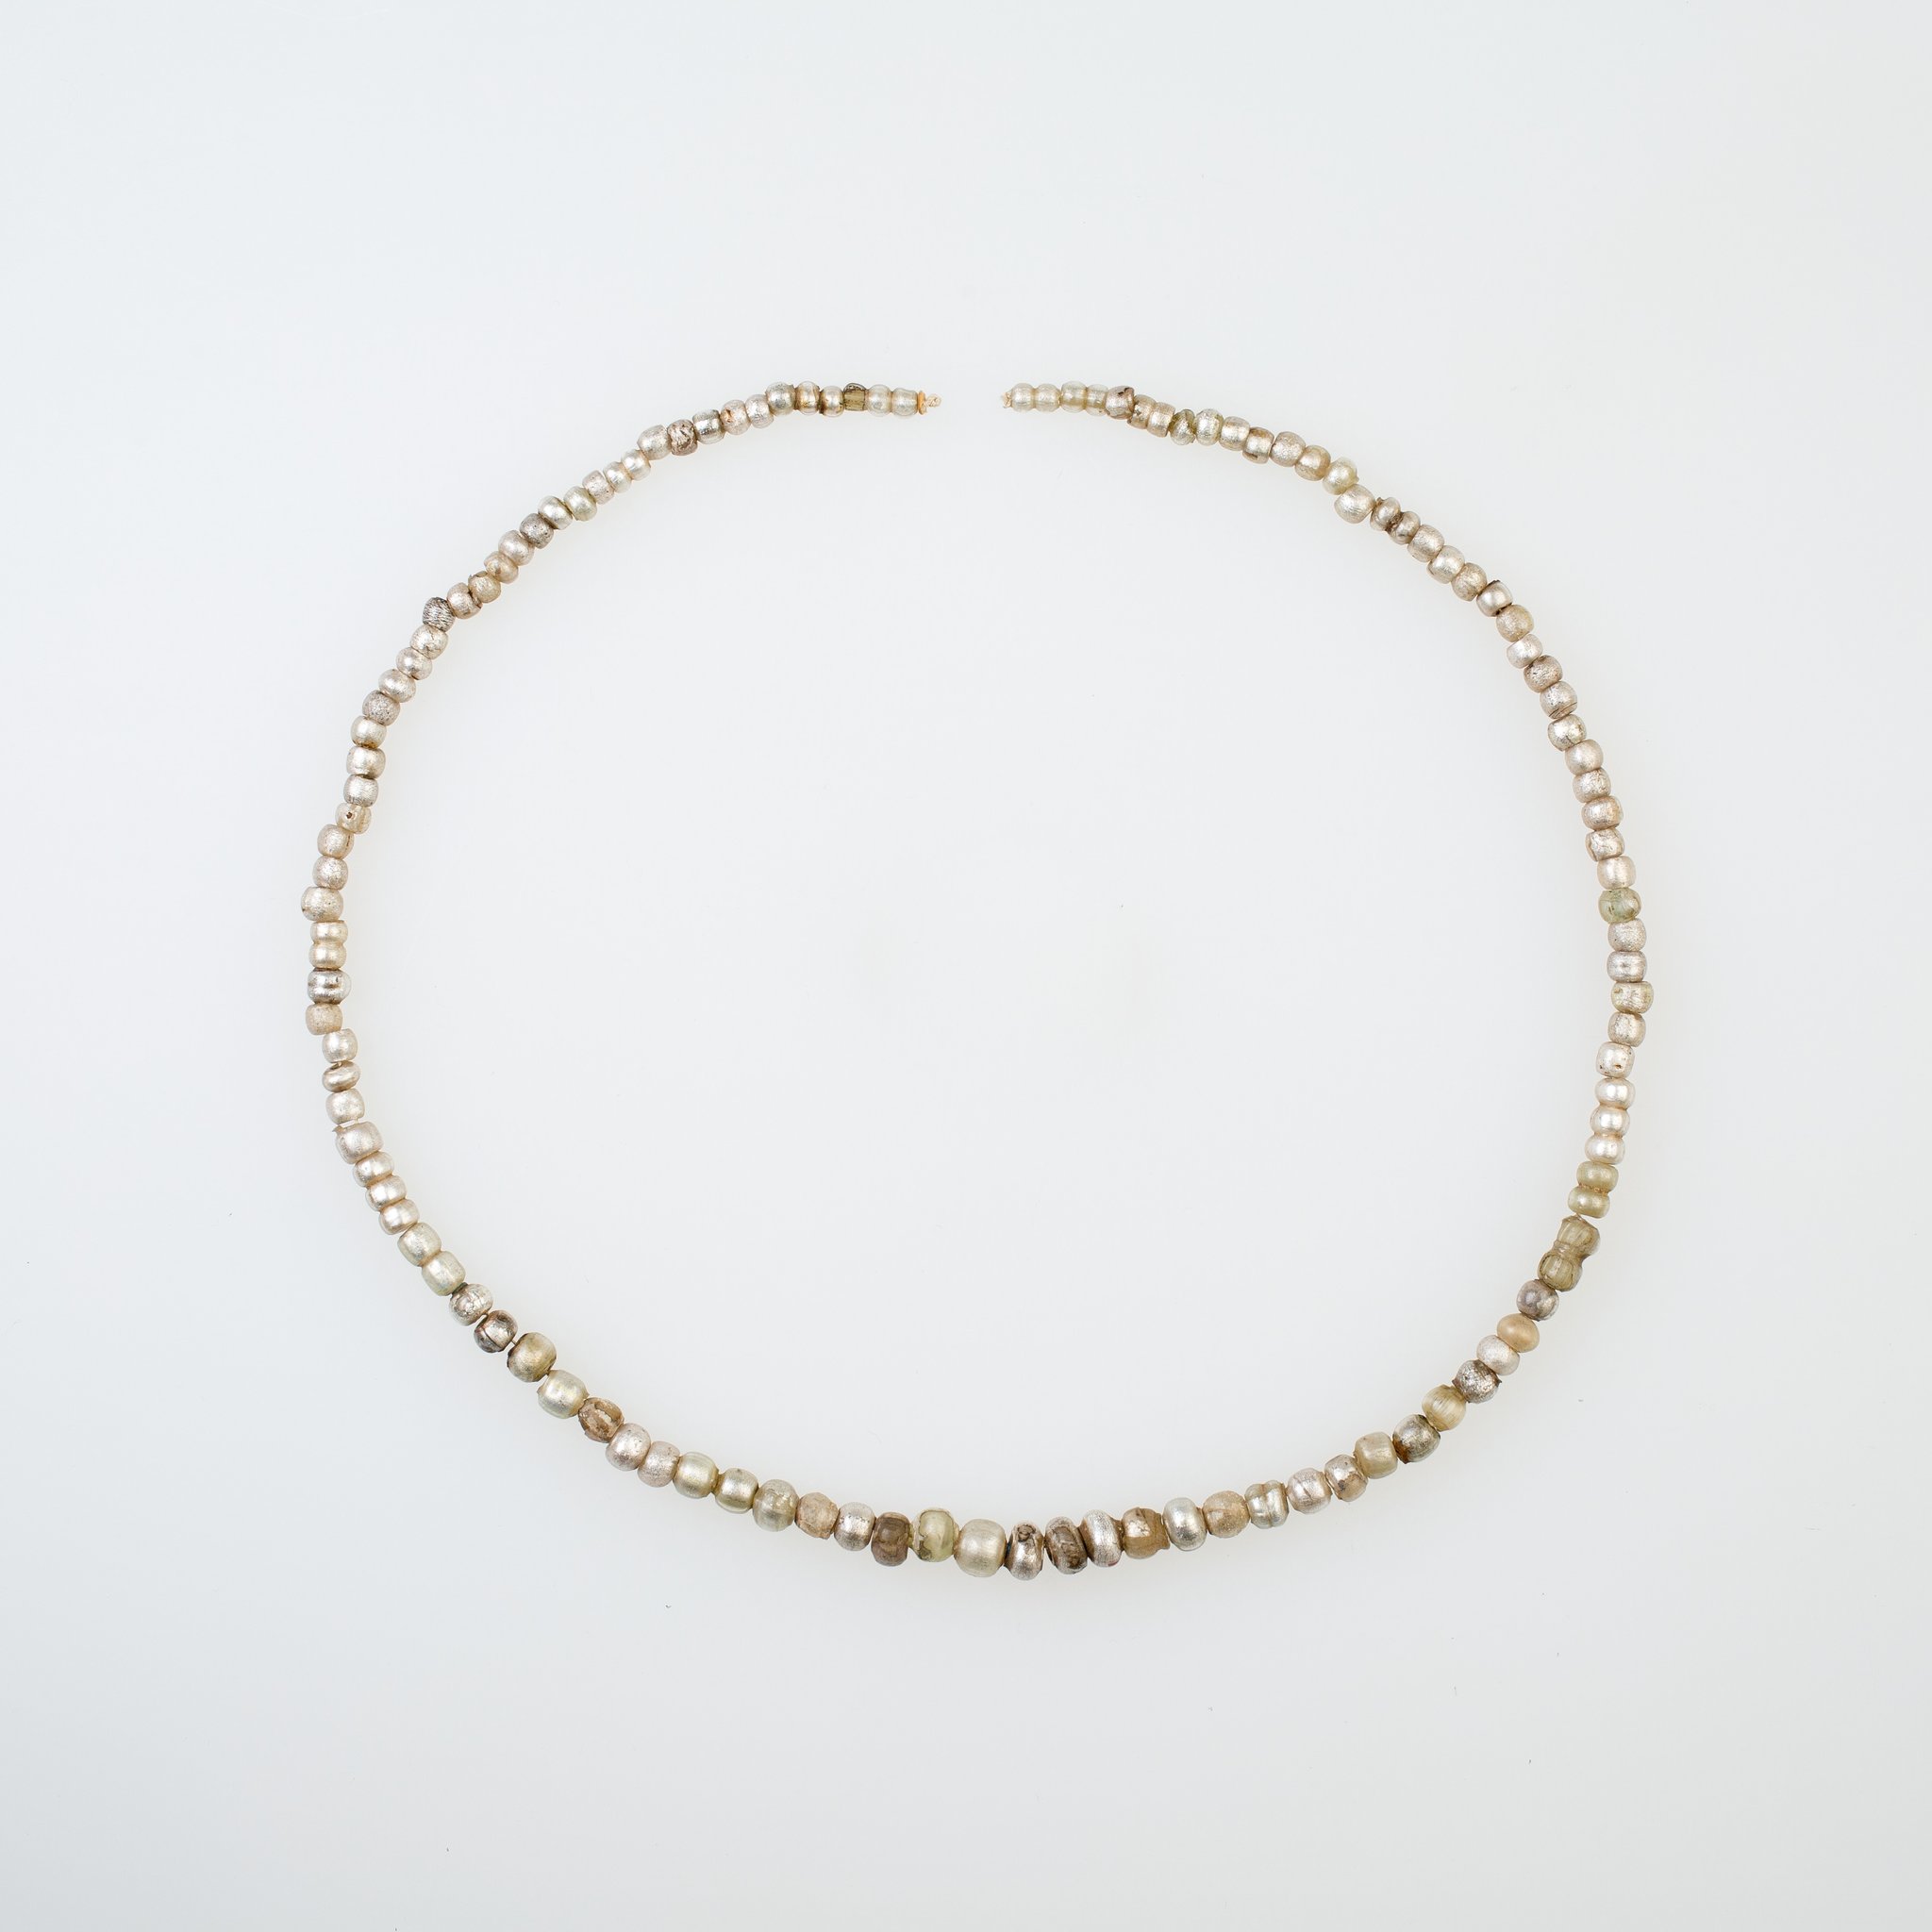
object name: bead, string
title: String of Beads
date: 200 BCE-200 CE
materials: glass, gold foil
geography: egypt